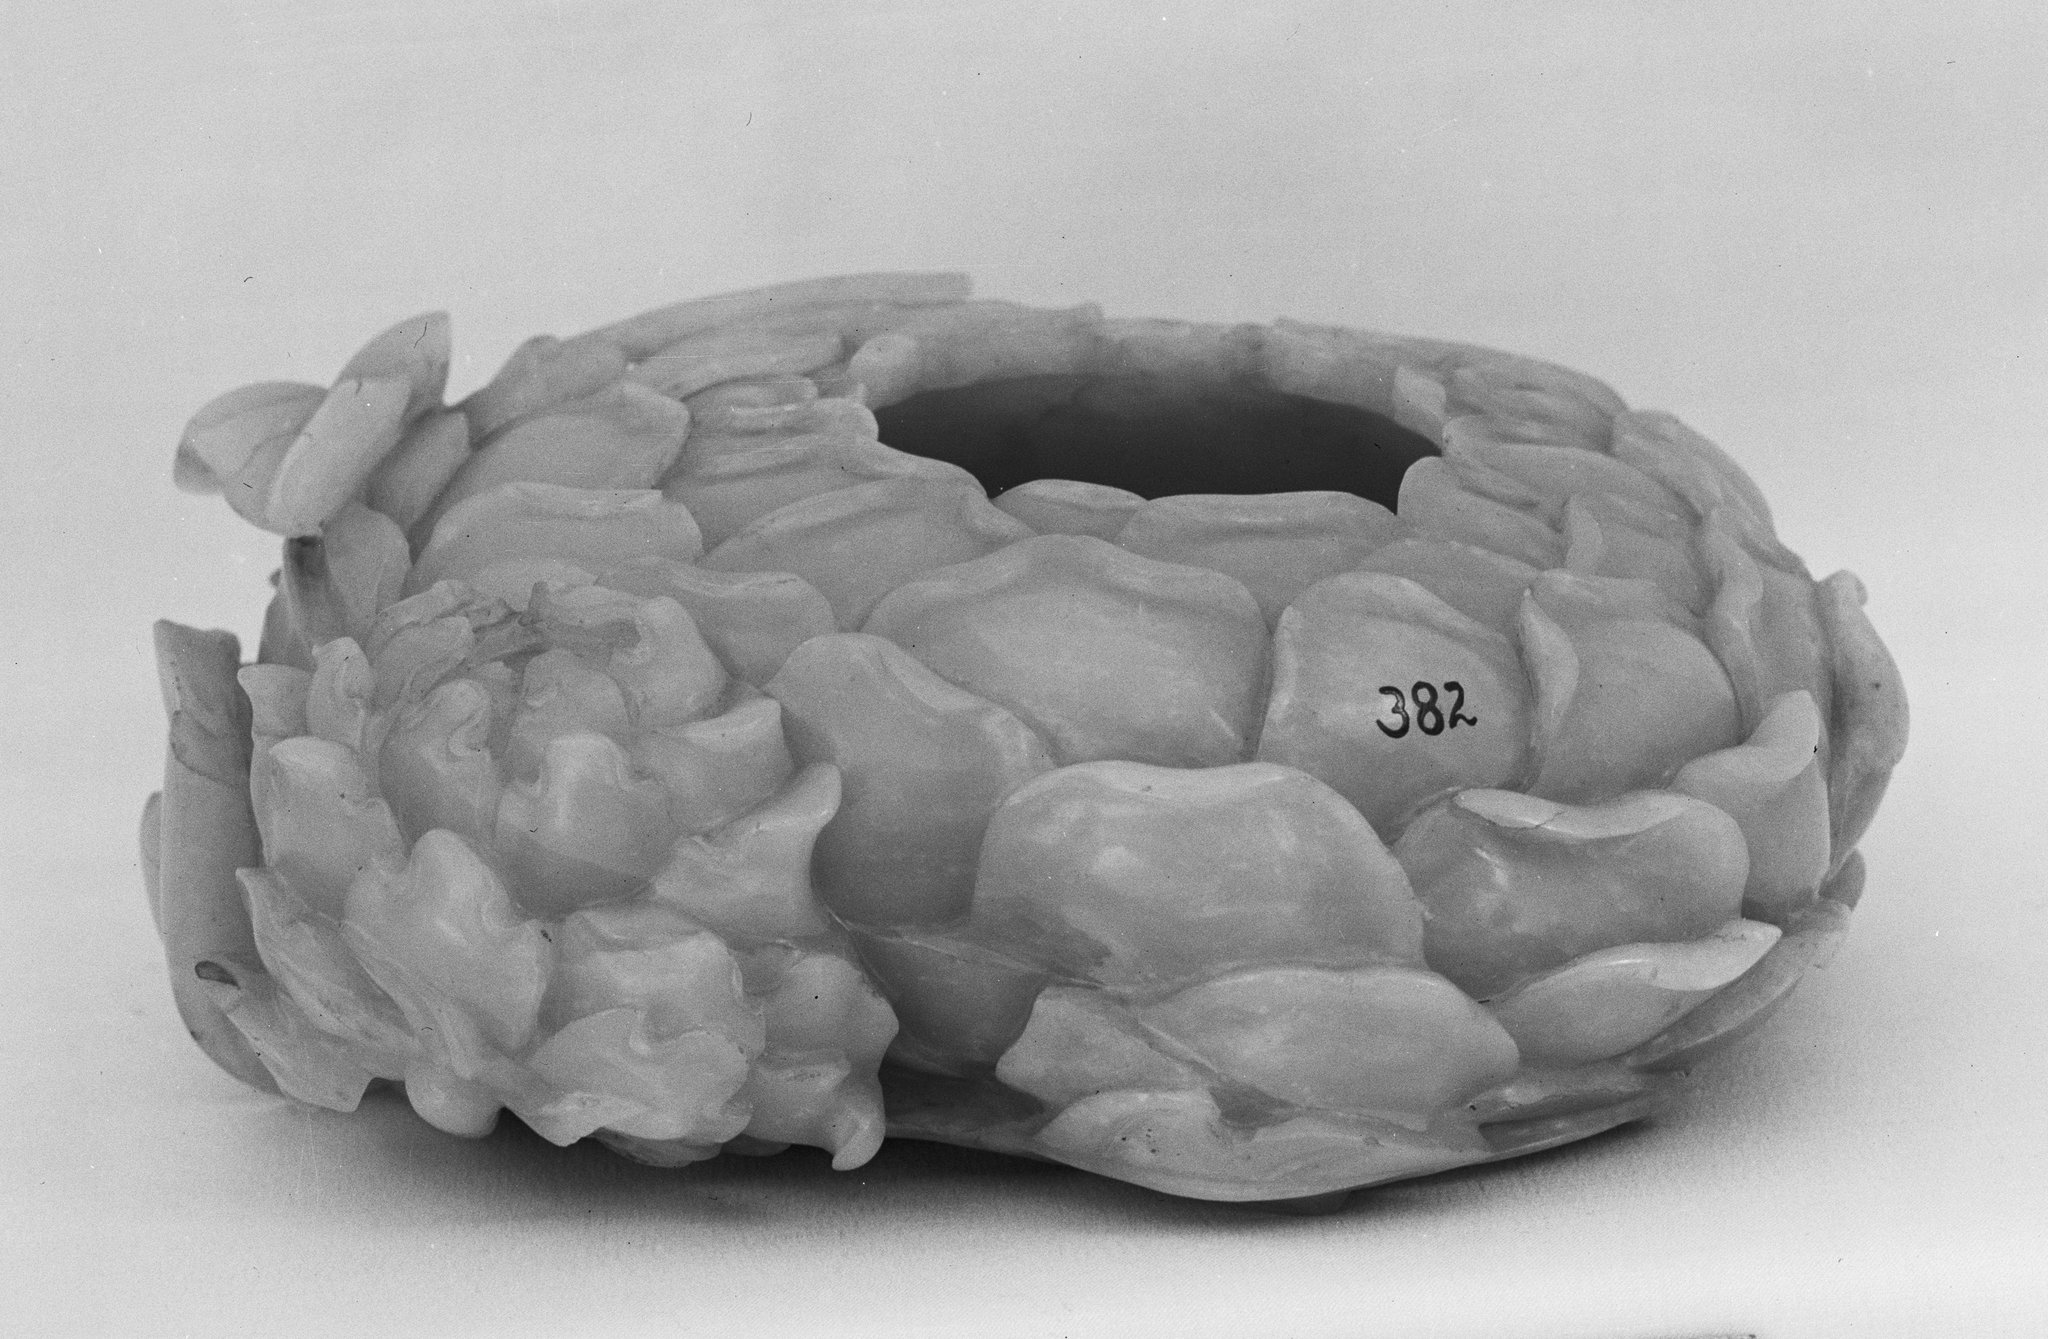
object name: water receptacle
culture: chinese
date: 1368-1644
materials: jade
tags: flowers